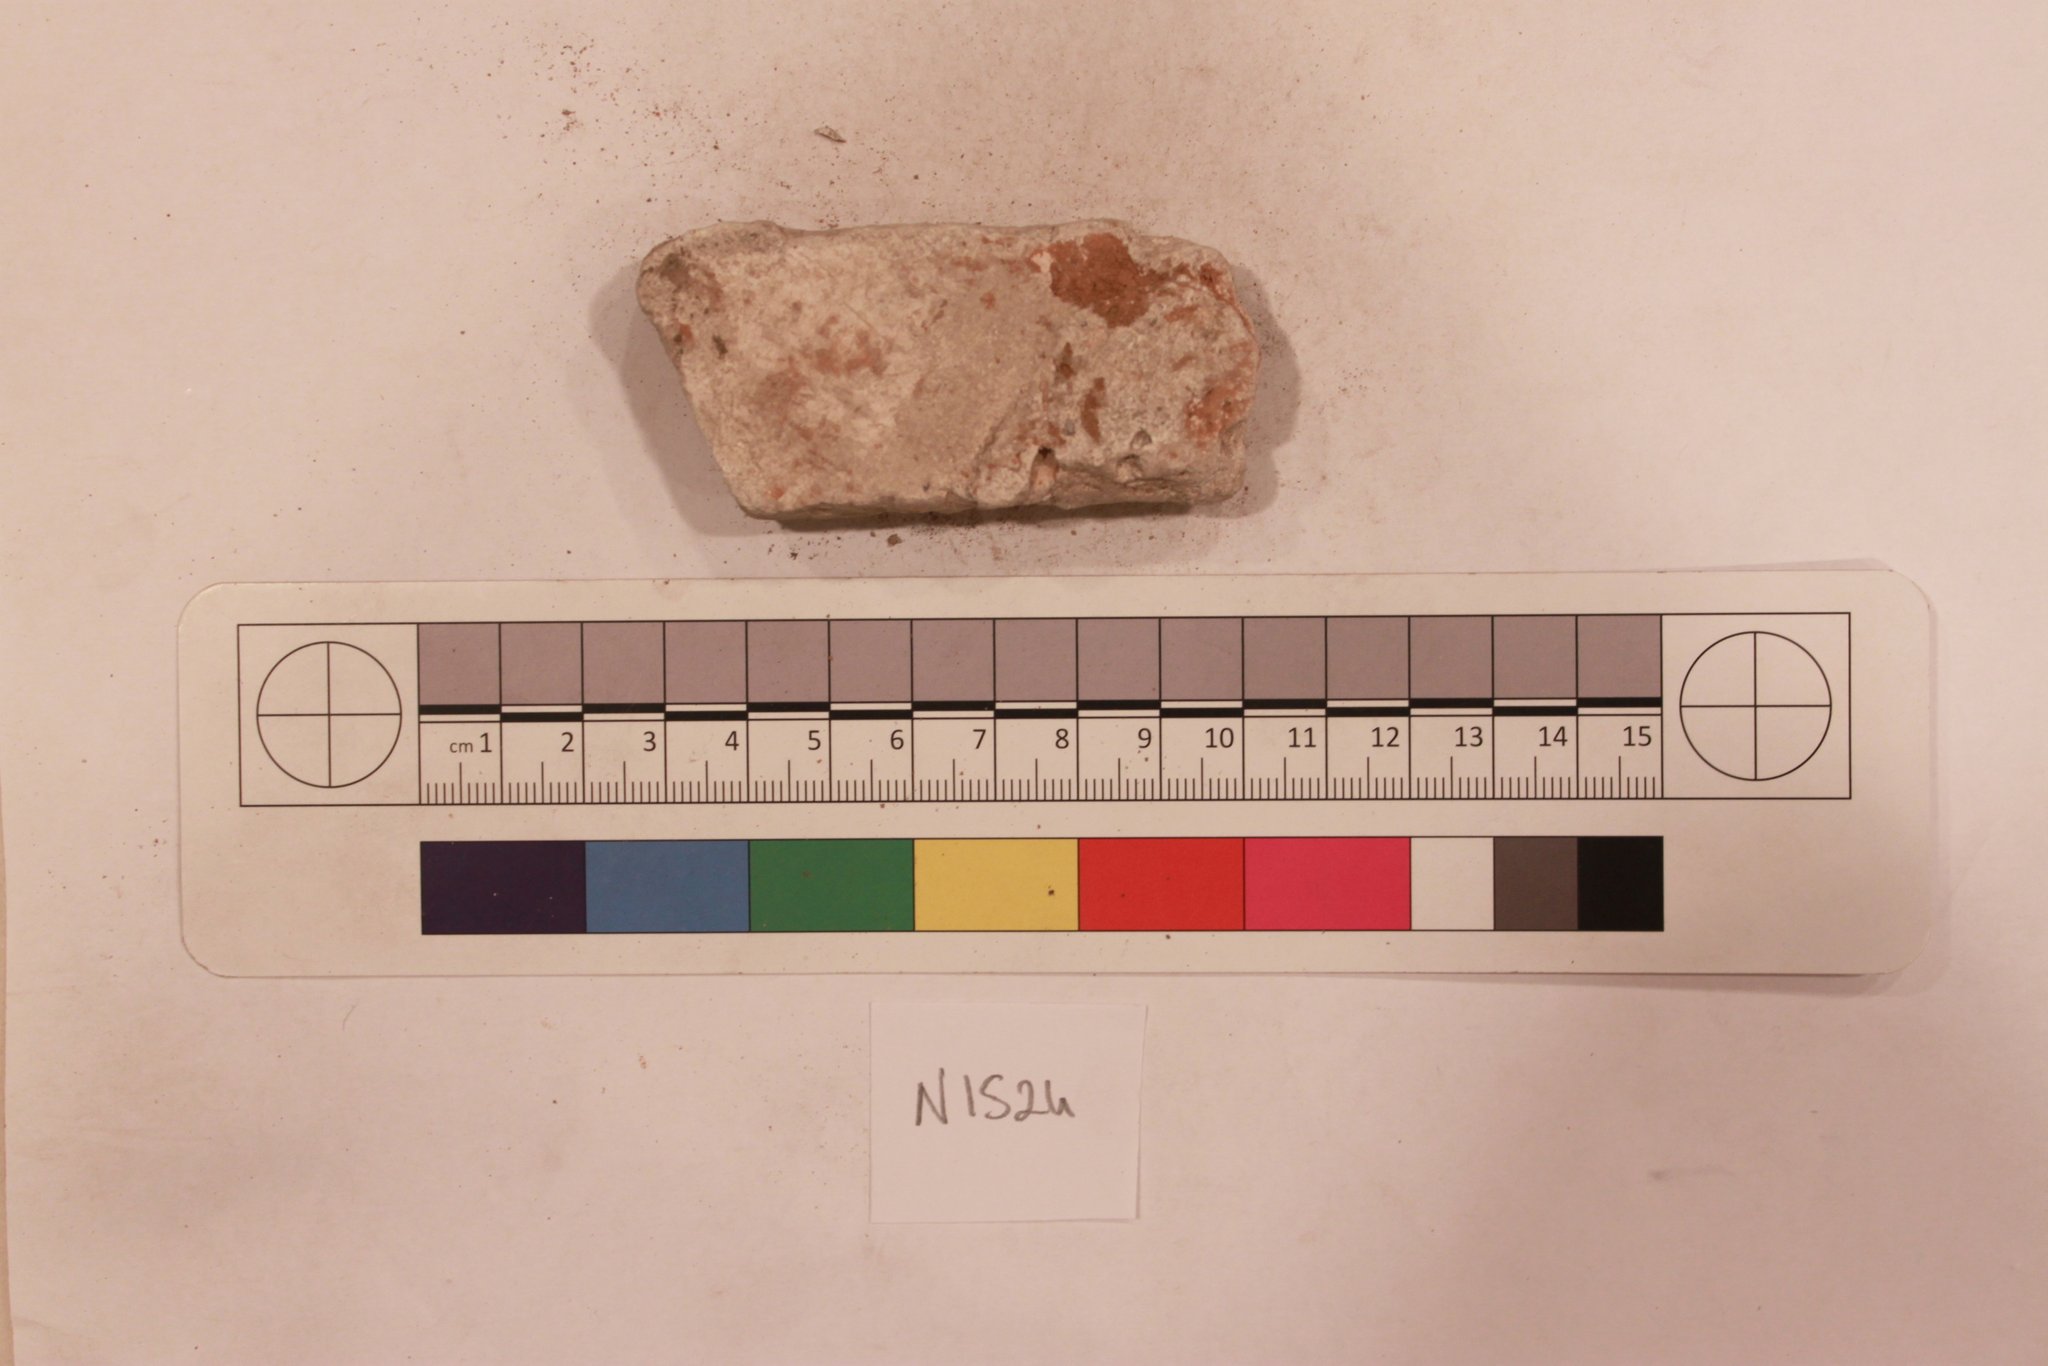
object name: fragment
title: Stucco Fragment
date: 701-1200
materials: plaster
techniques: carving, painting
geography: iran